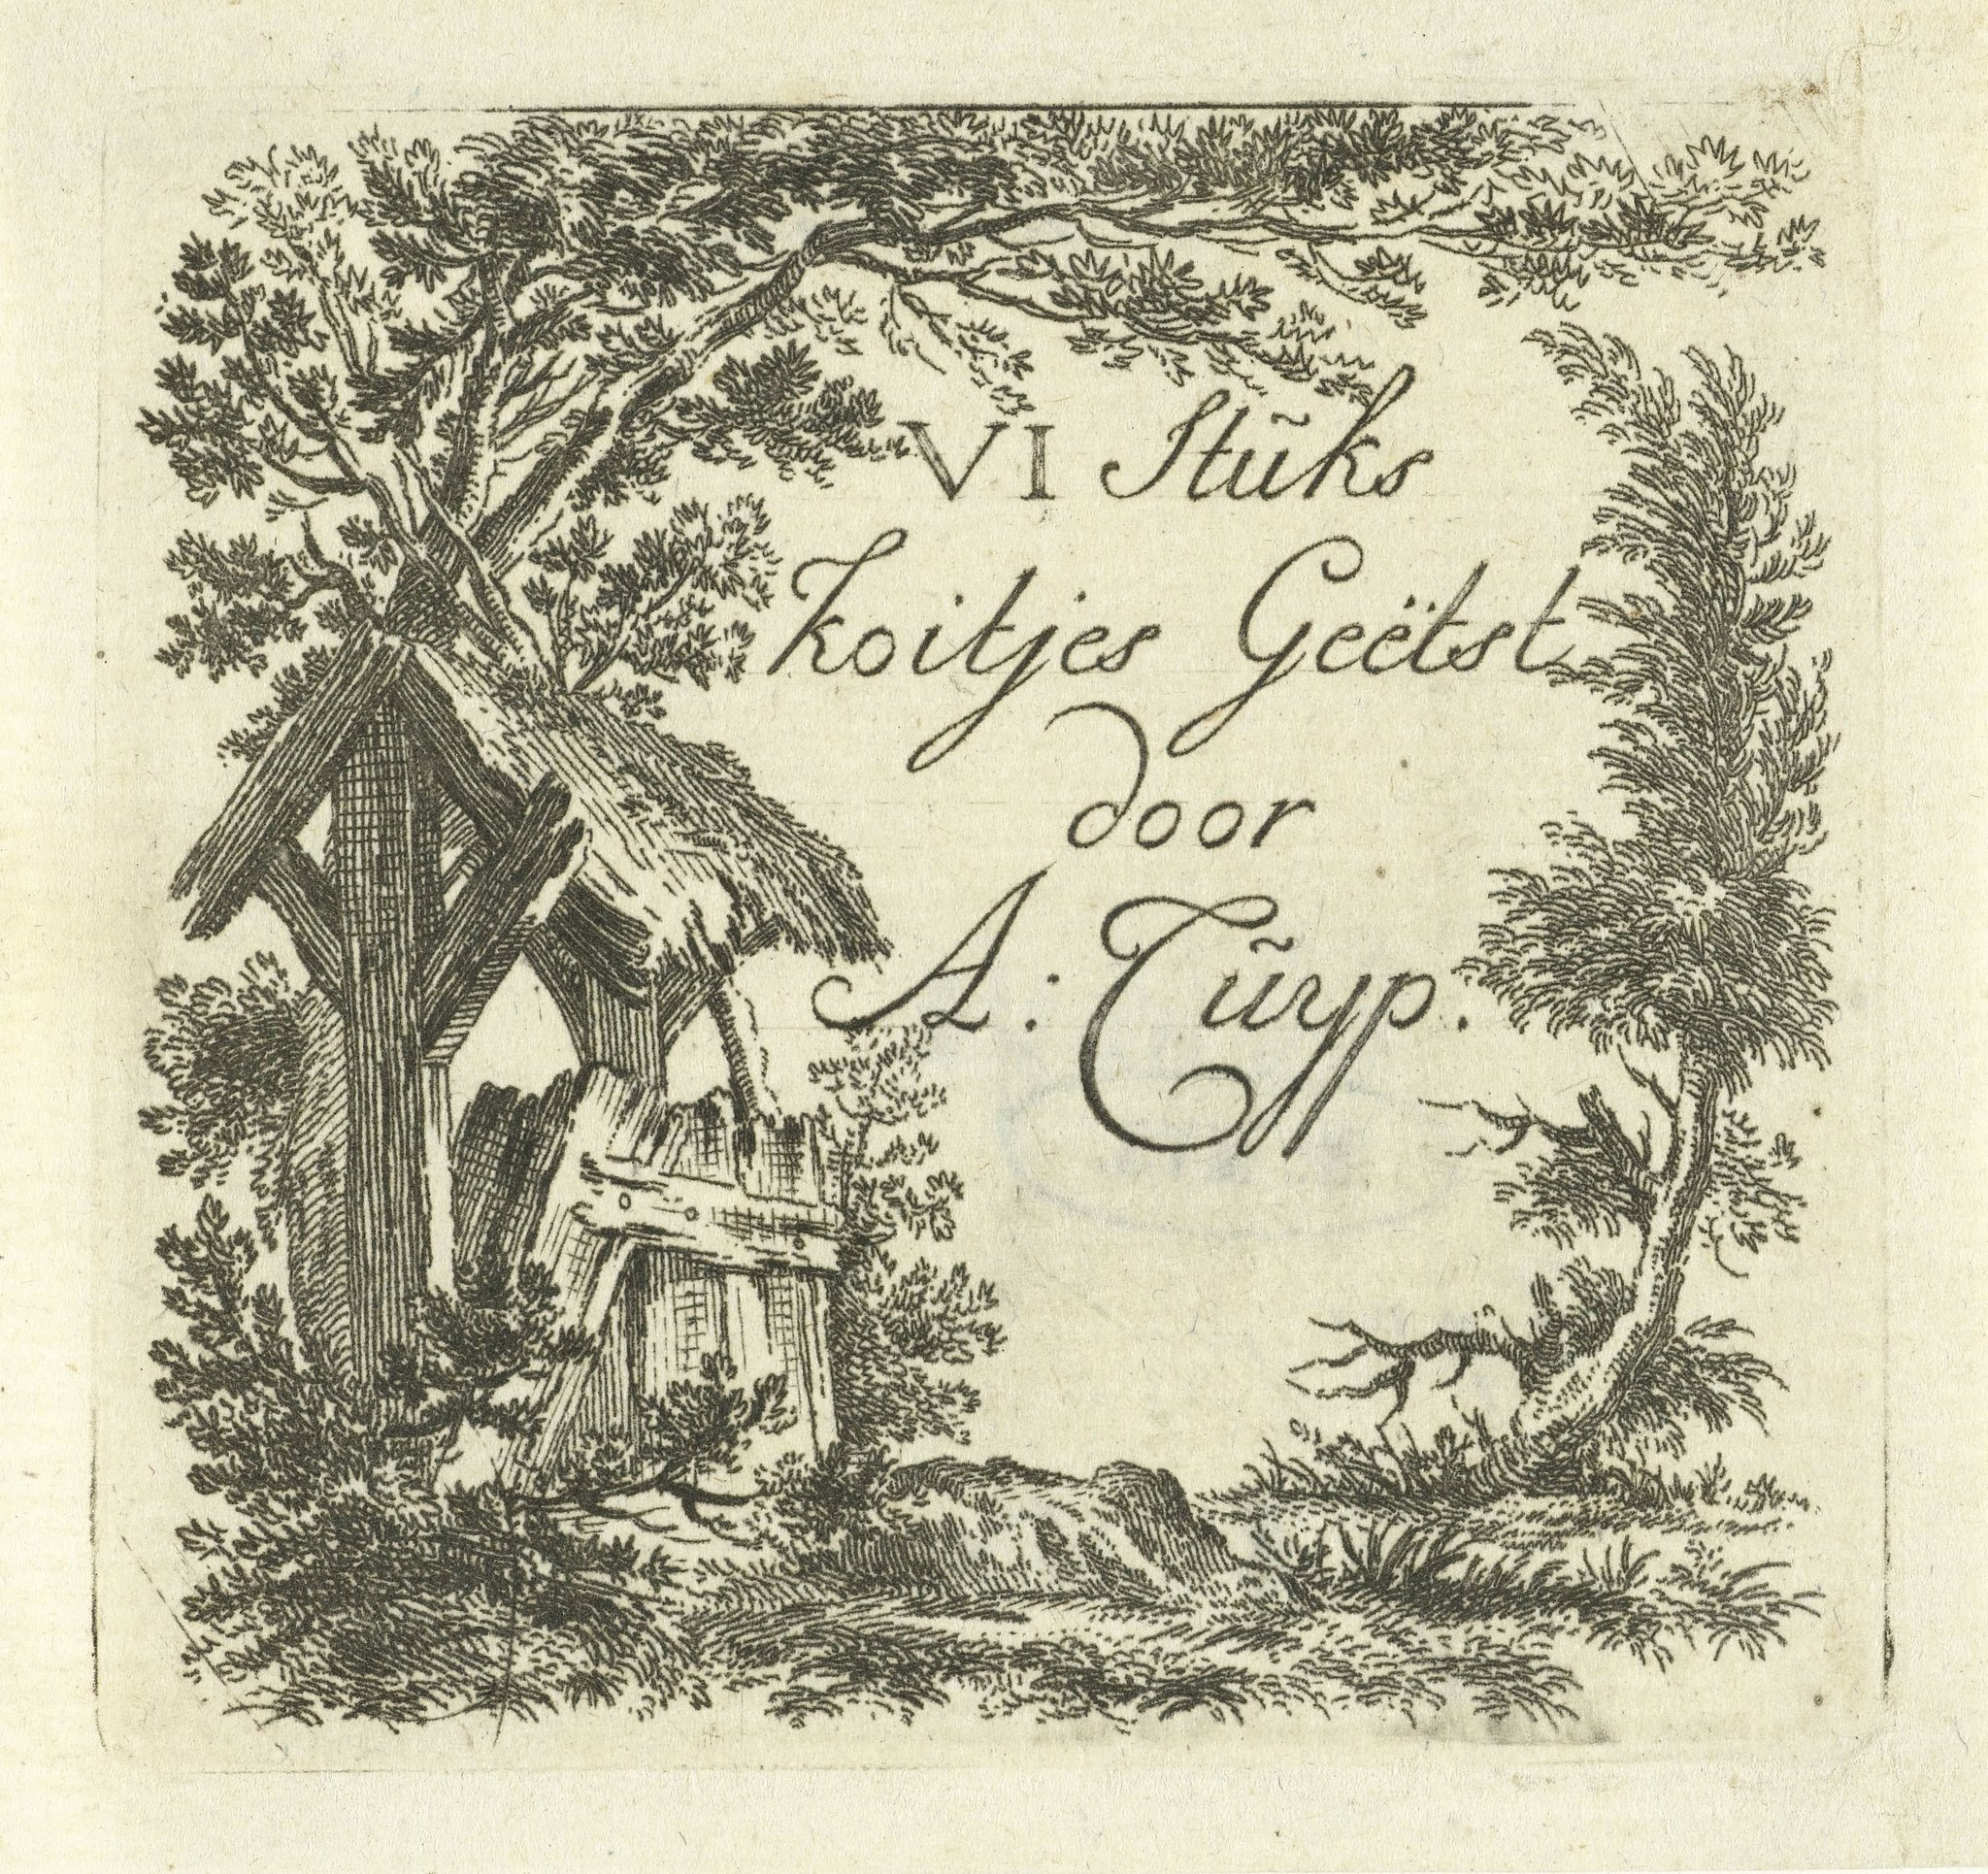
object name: print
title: Koeien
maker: Anonymous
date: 1630-1691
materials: paper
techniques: etching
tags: gate, entrance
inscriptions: collector's mark: Lugt 2228, collector's mark: ‘F Rechberger 1856’ Lugt 2133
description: Titelprent voor serie van zes prenten met koeien van Albert Cuyp. In de derde staat van de serie werd de titelprent door een anonieme vervaardiger toegevoegd (zie documentatie).